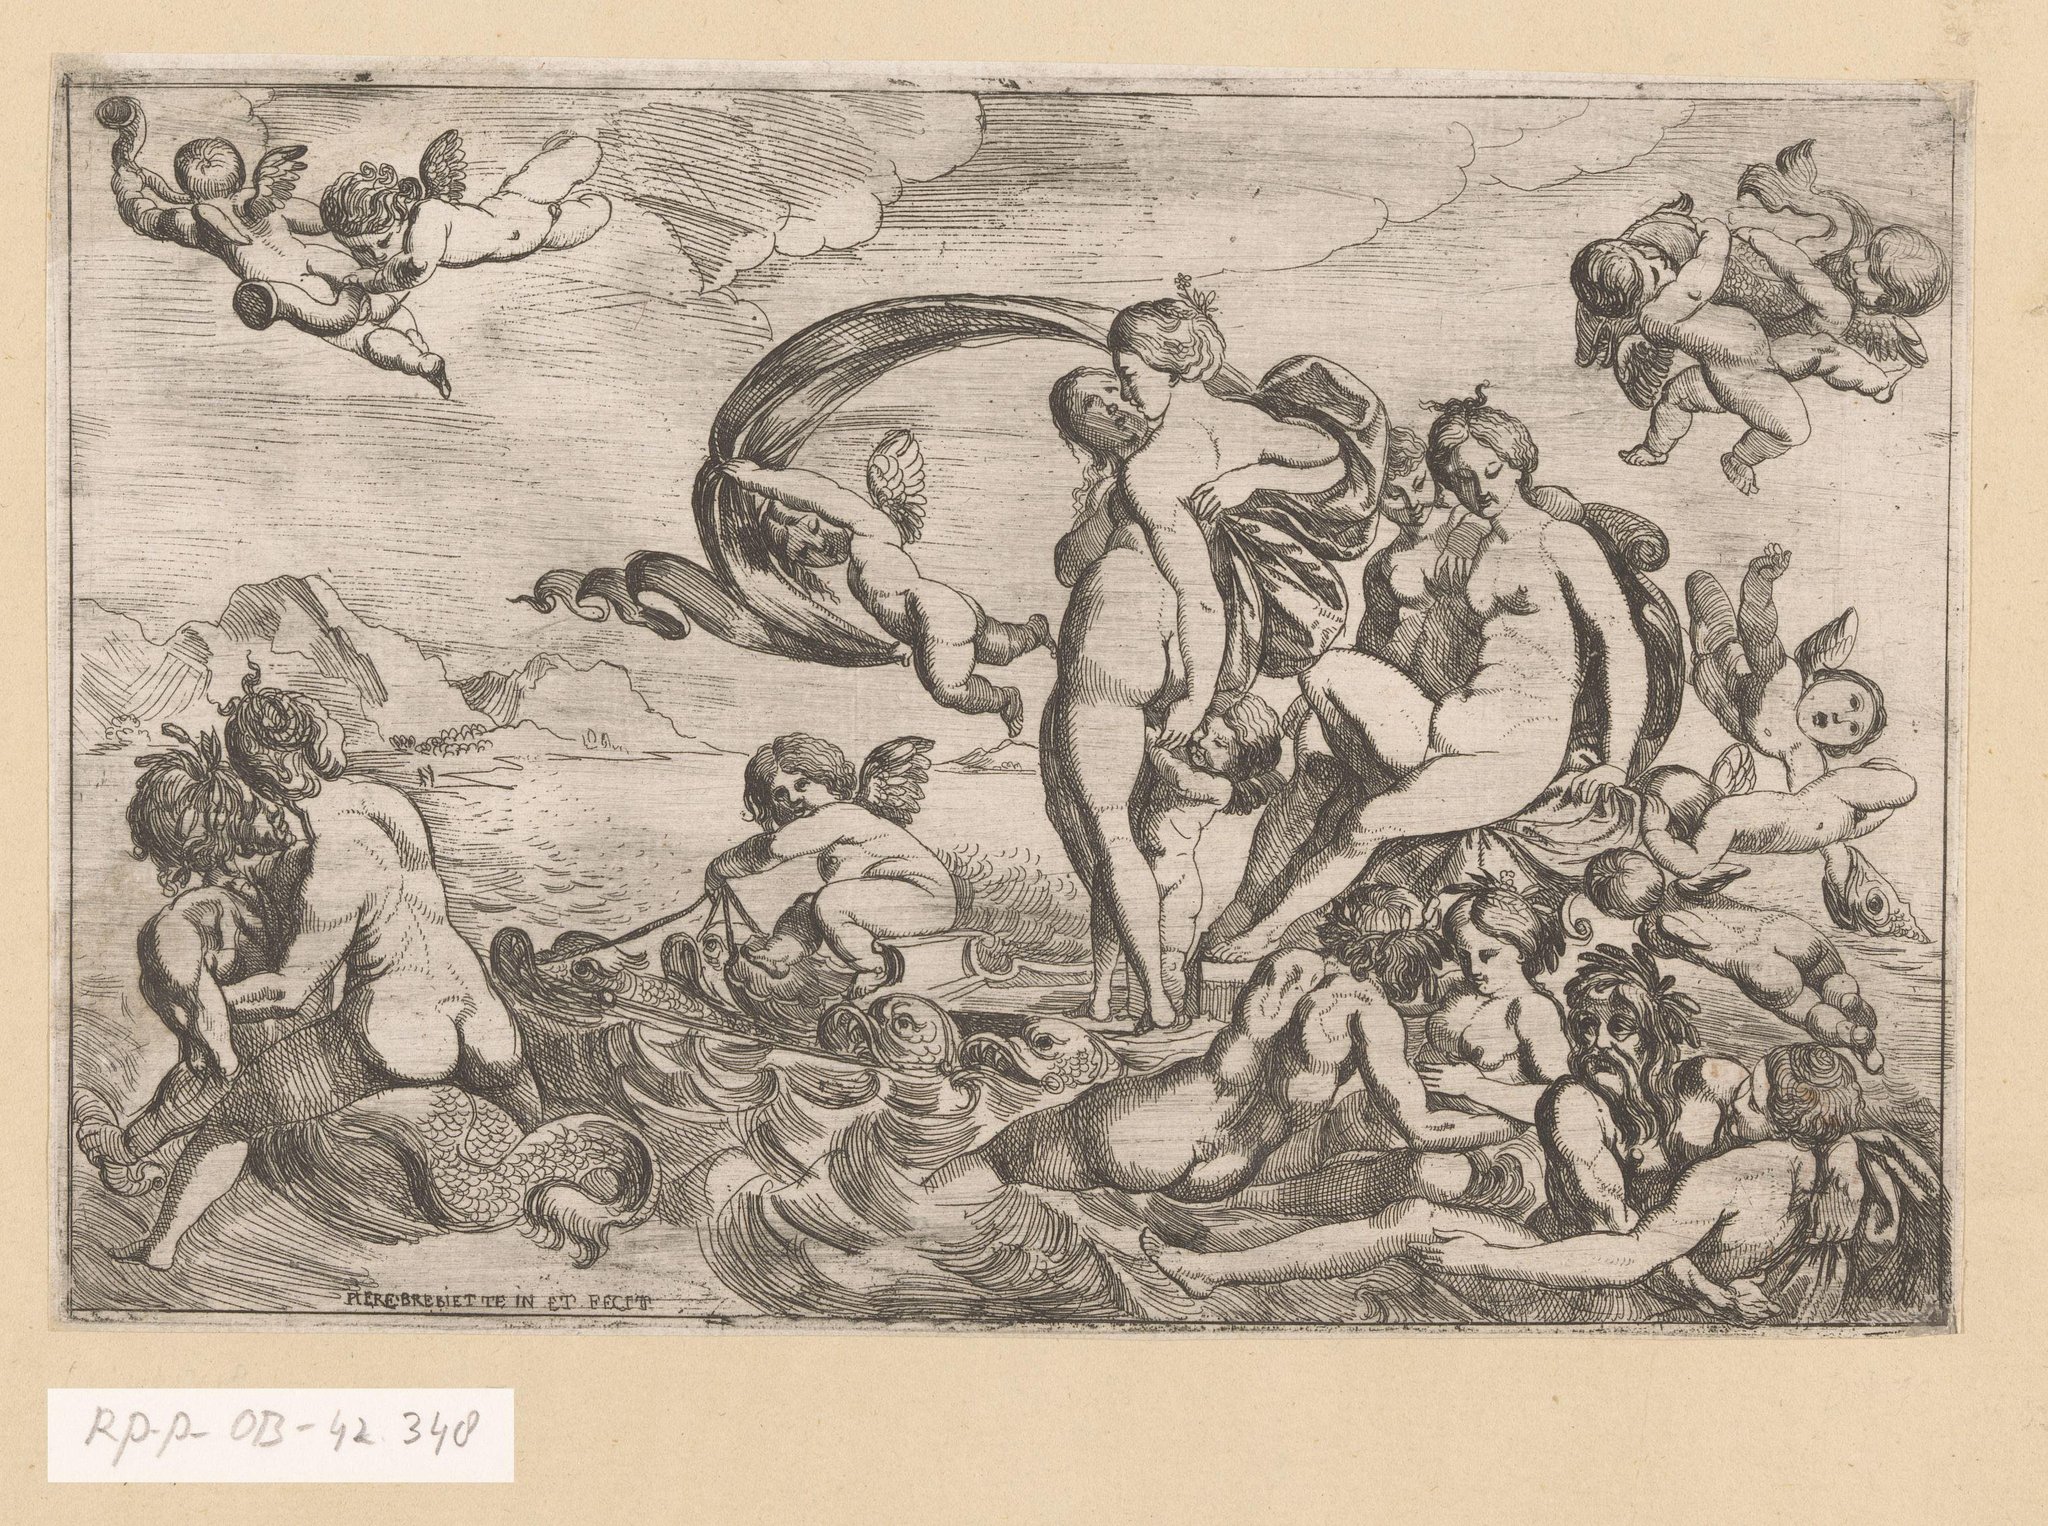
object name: print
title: Zeegodinnen op een vaartuig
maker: pierre brebiette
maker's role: draughtsman, print maker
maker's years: 1598-1650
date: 1608-1650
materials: paper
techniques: etching, intaglio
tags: gods of the waters: the older dynasty (second series): children of oceanus, river and small water deities, sea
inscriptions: collector's mark: Lugt 240